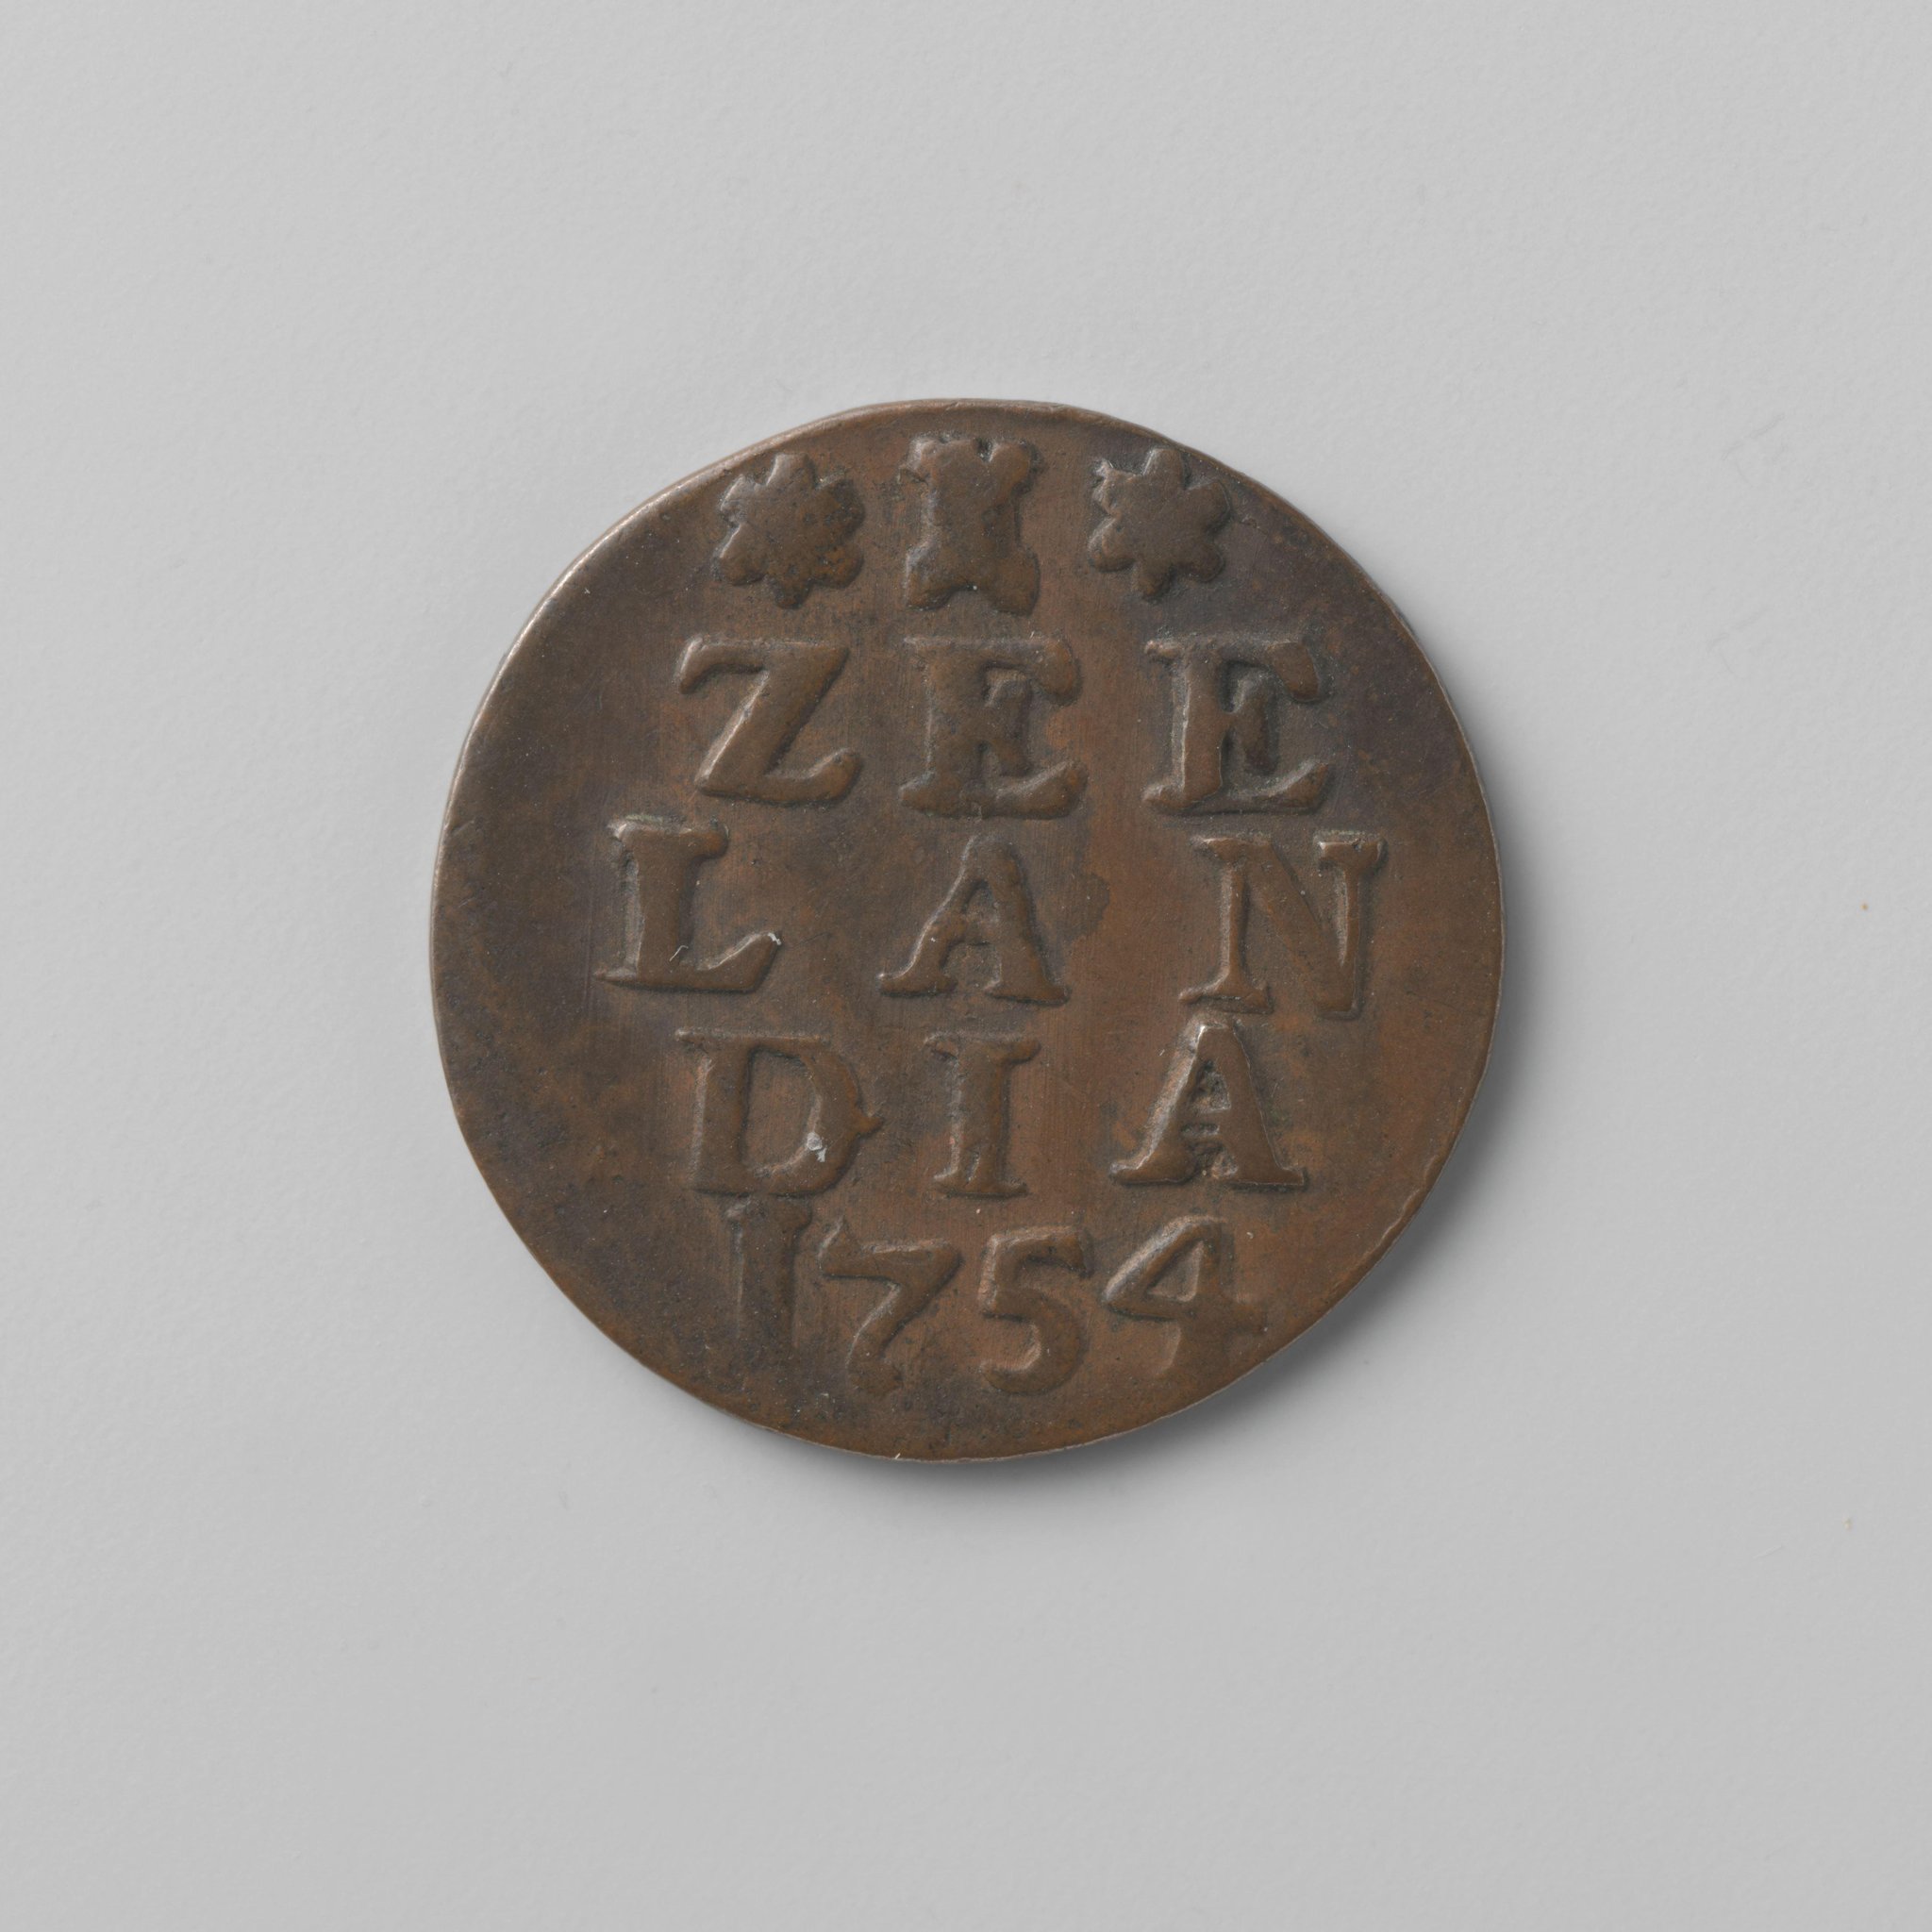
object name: coin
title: Zeeuwse duit, 1754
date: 1754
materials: copper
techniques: striking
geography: middelburg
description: Voorzijde: gekroond, zijdelings ingedeukt wapenschild van Zeeland, omschrift eindigend in EMENTOR. Keerzijde: opschrift in drie regels, waarboven muntteken burcht tussen twee sterren en waaronder jaartal..